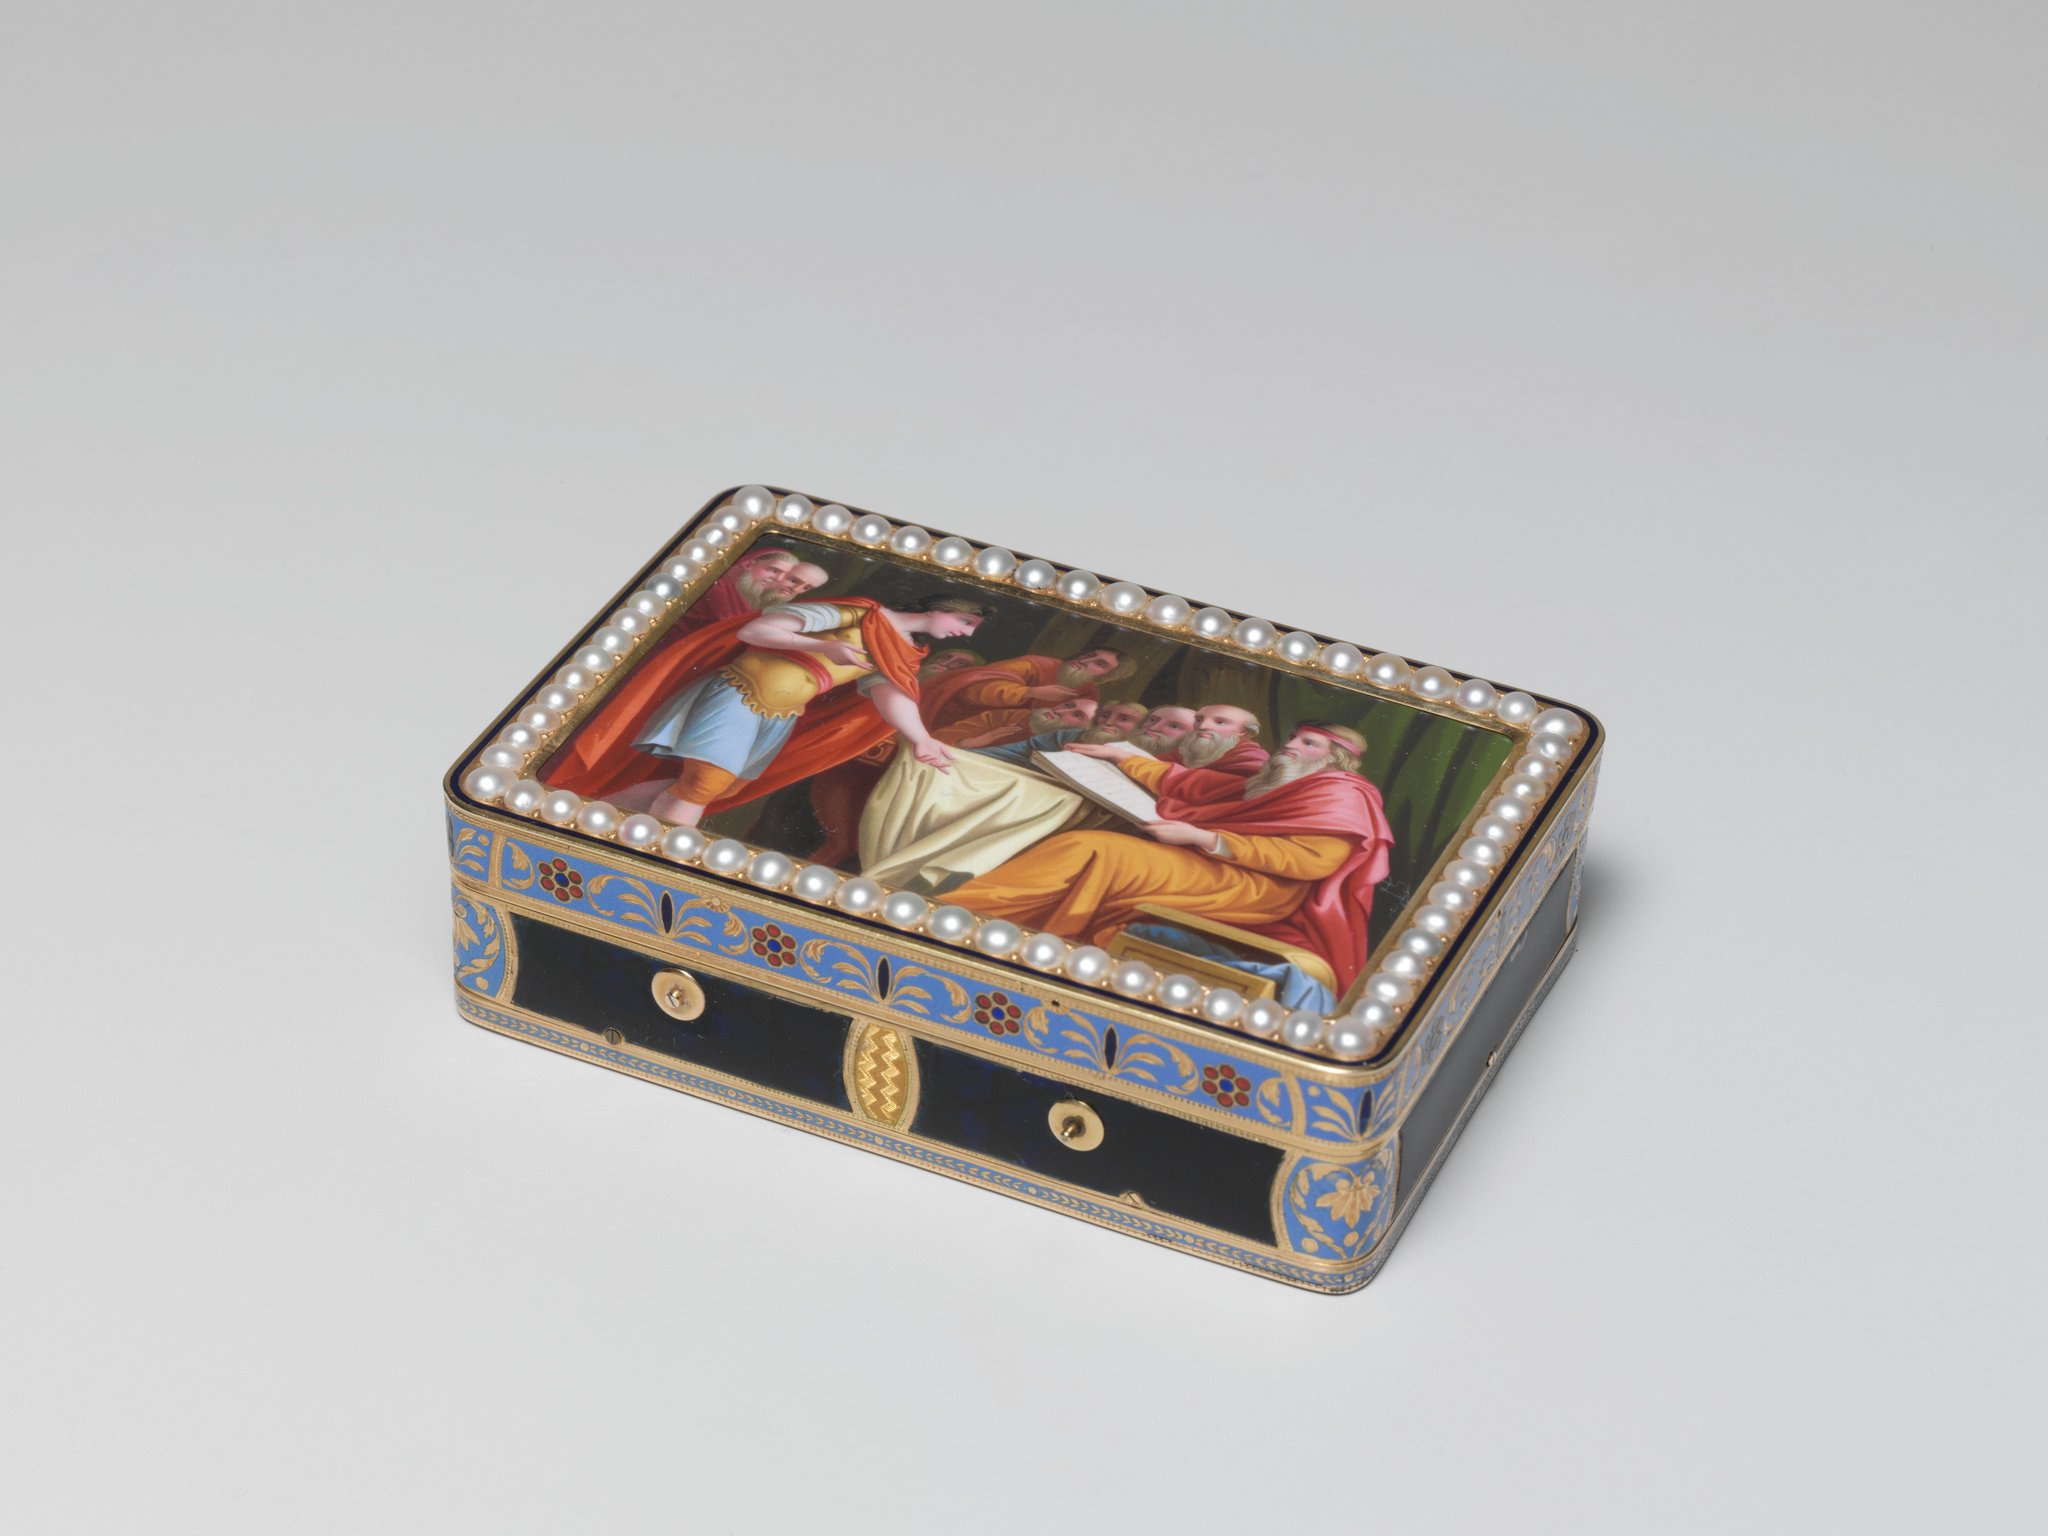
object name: music box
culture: swiss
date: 1820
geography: switzerland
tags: men